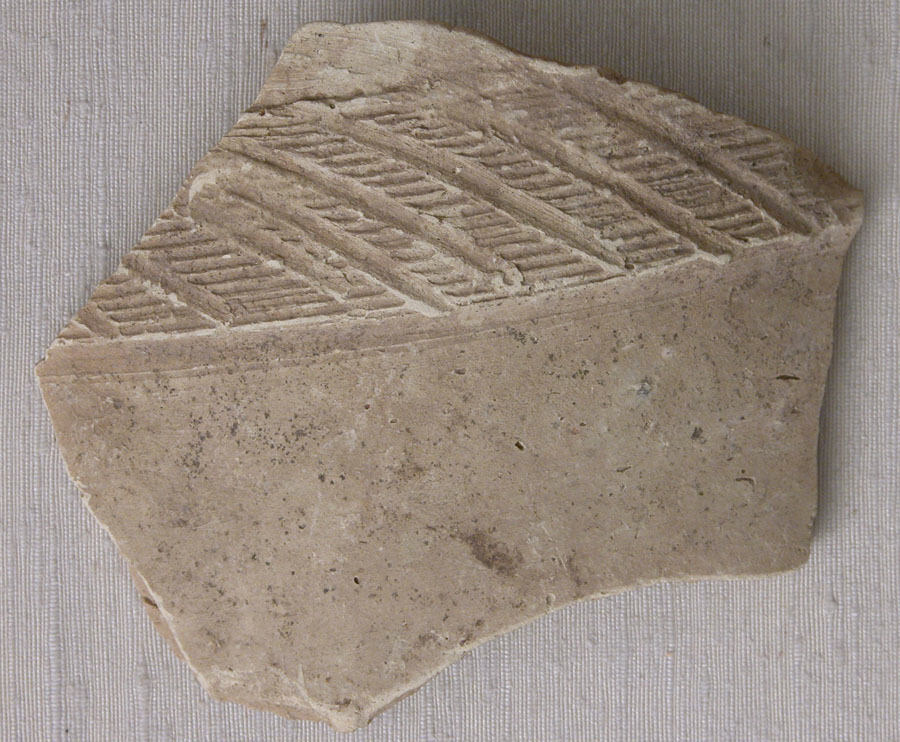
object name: fragment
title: Ceramic Fragment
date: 701-900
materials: earthenware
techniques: stamping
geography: iraq